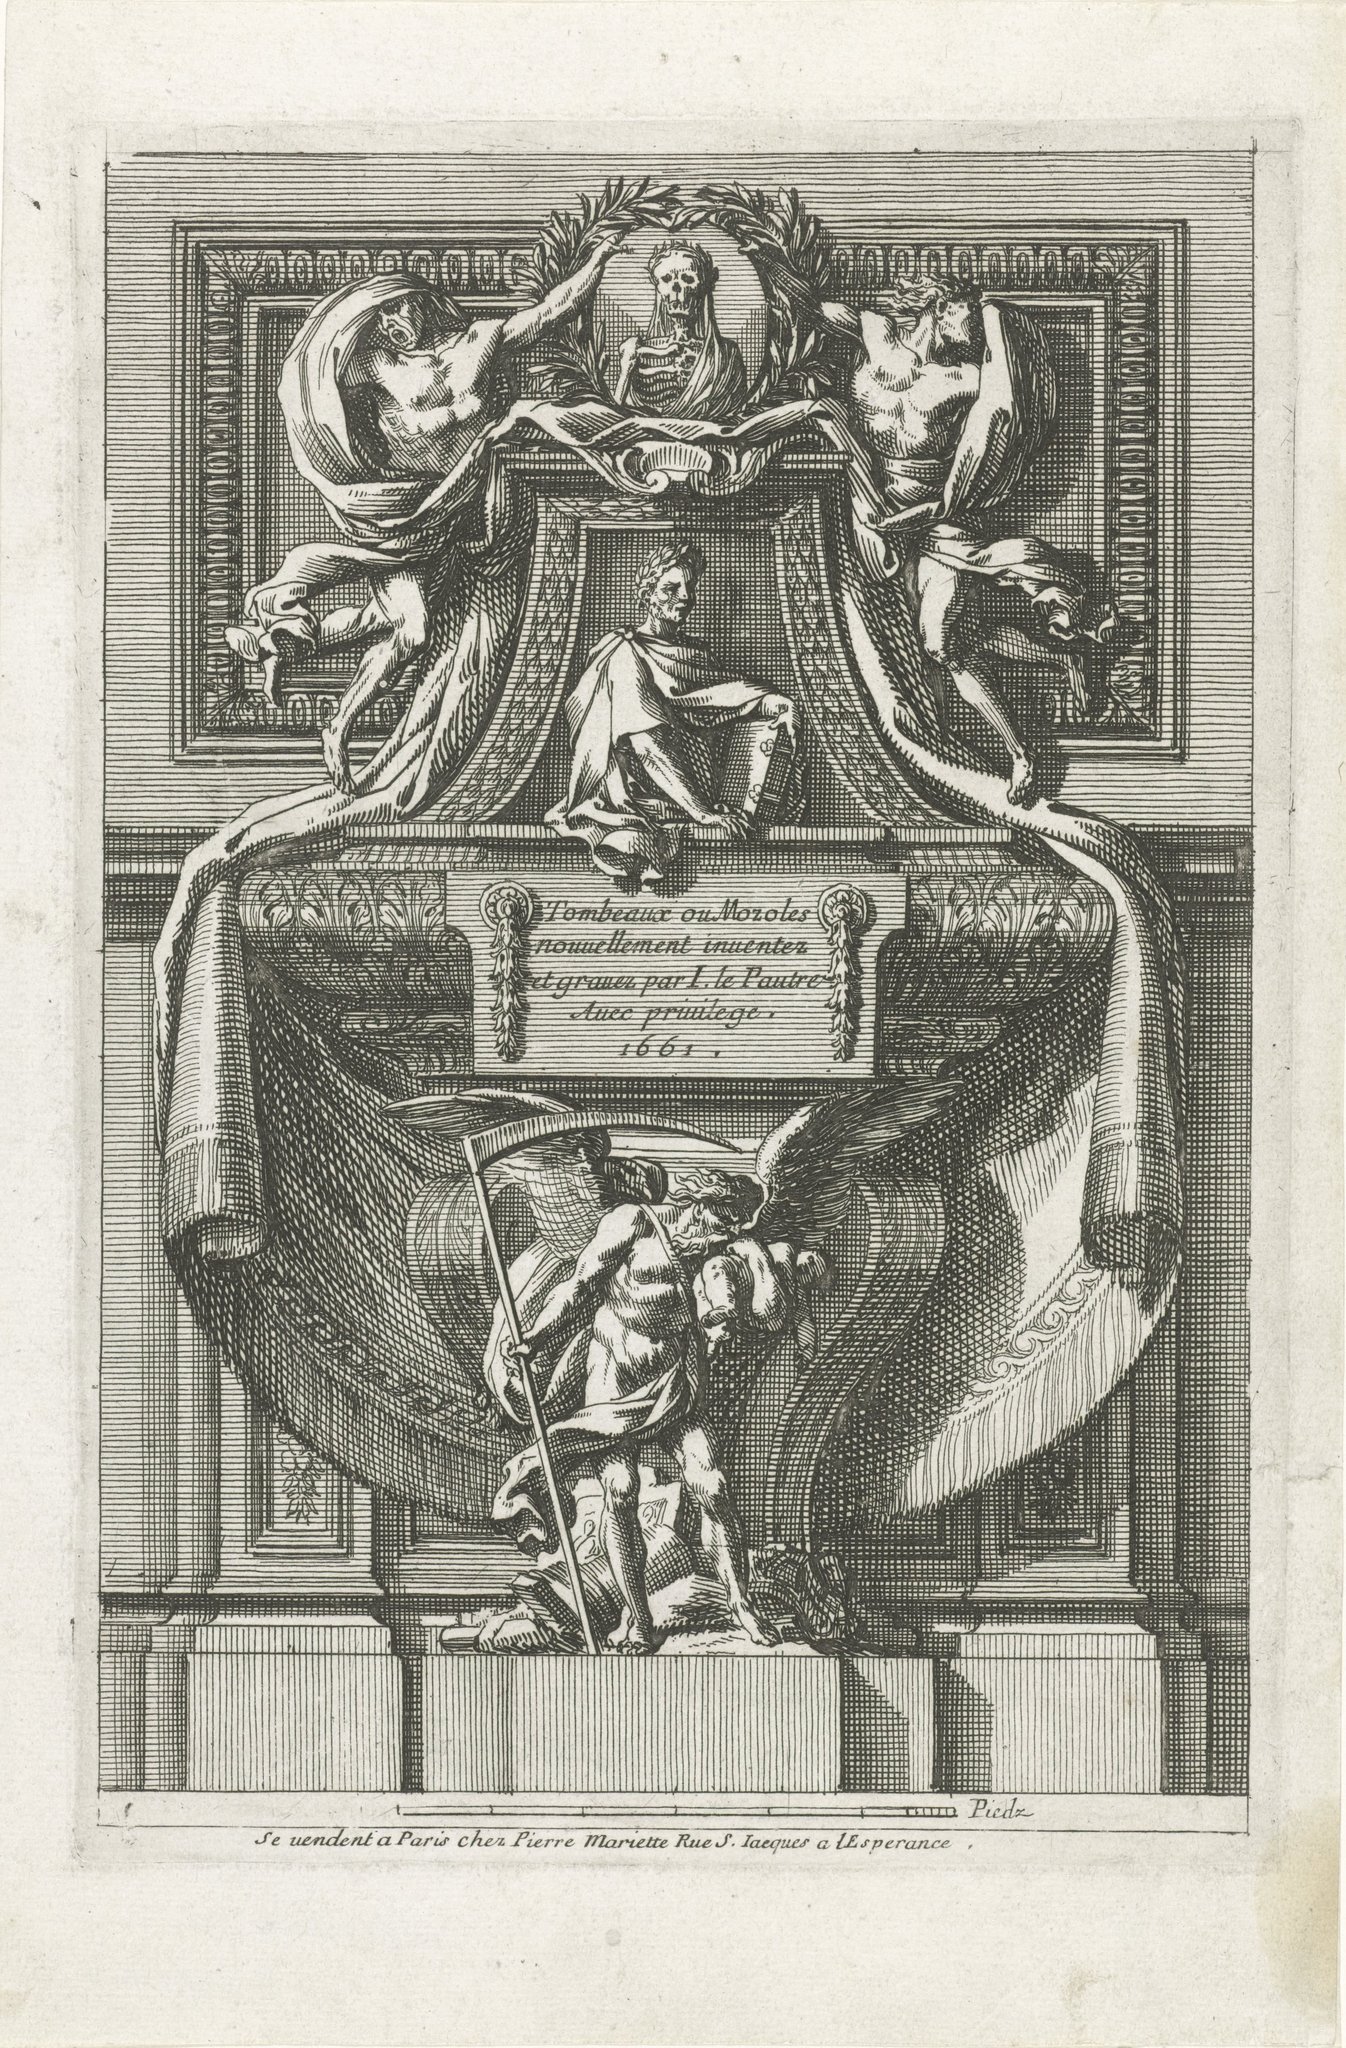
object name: ornament print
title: Titelblad: Tombeaux ou Mozoles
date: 1661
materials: paper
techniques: etching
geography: paris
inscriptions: date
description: Grafmonument tegen een muur met de buste van een Romeinse keizer op een kist. Onderaan staat de Tijd. Uit serie van titelblad en 5 bladen, derde editie.